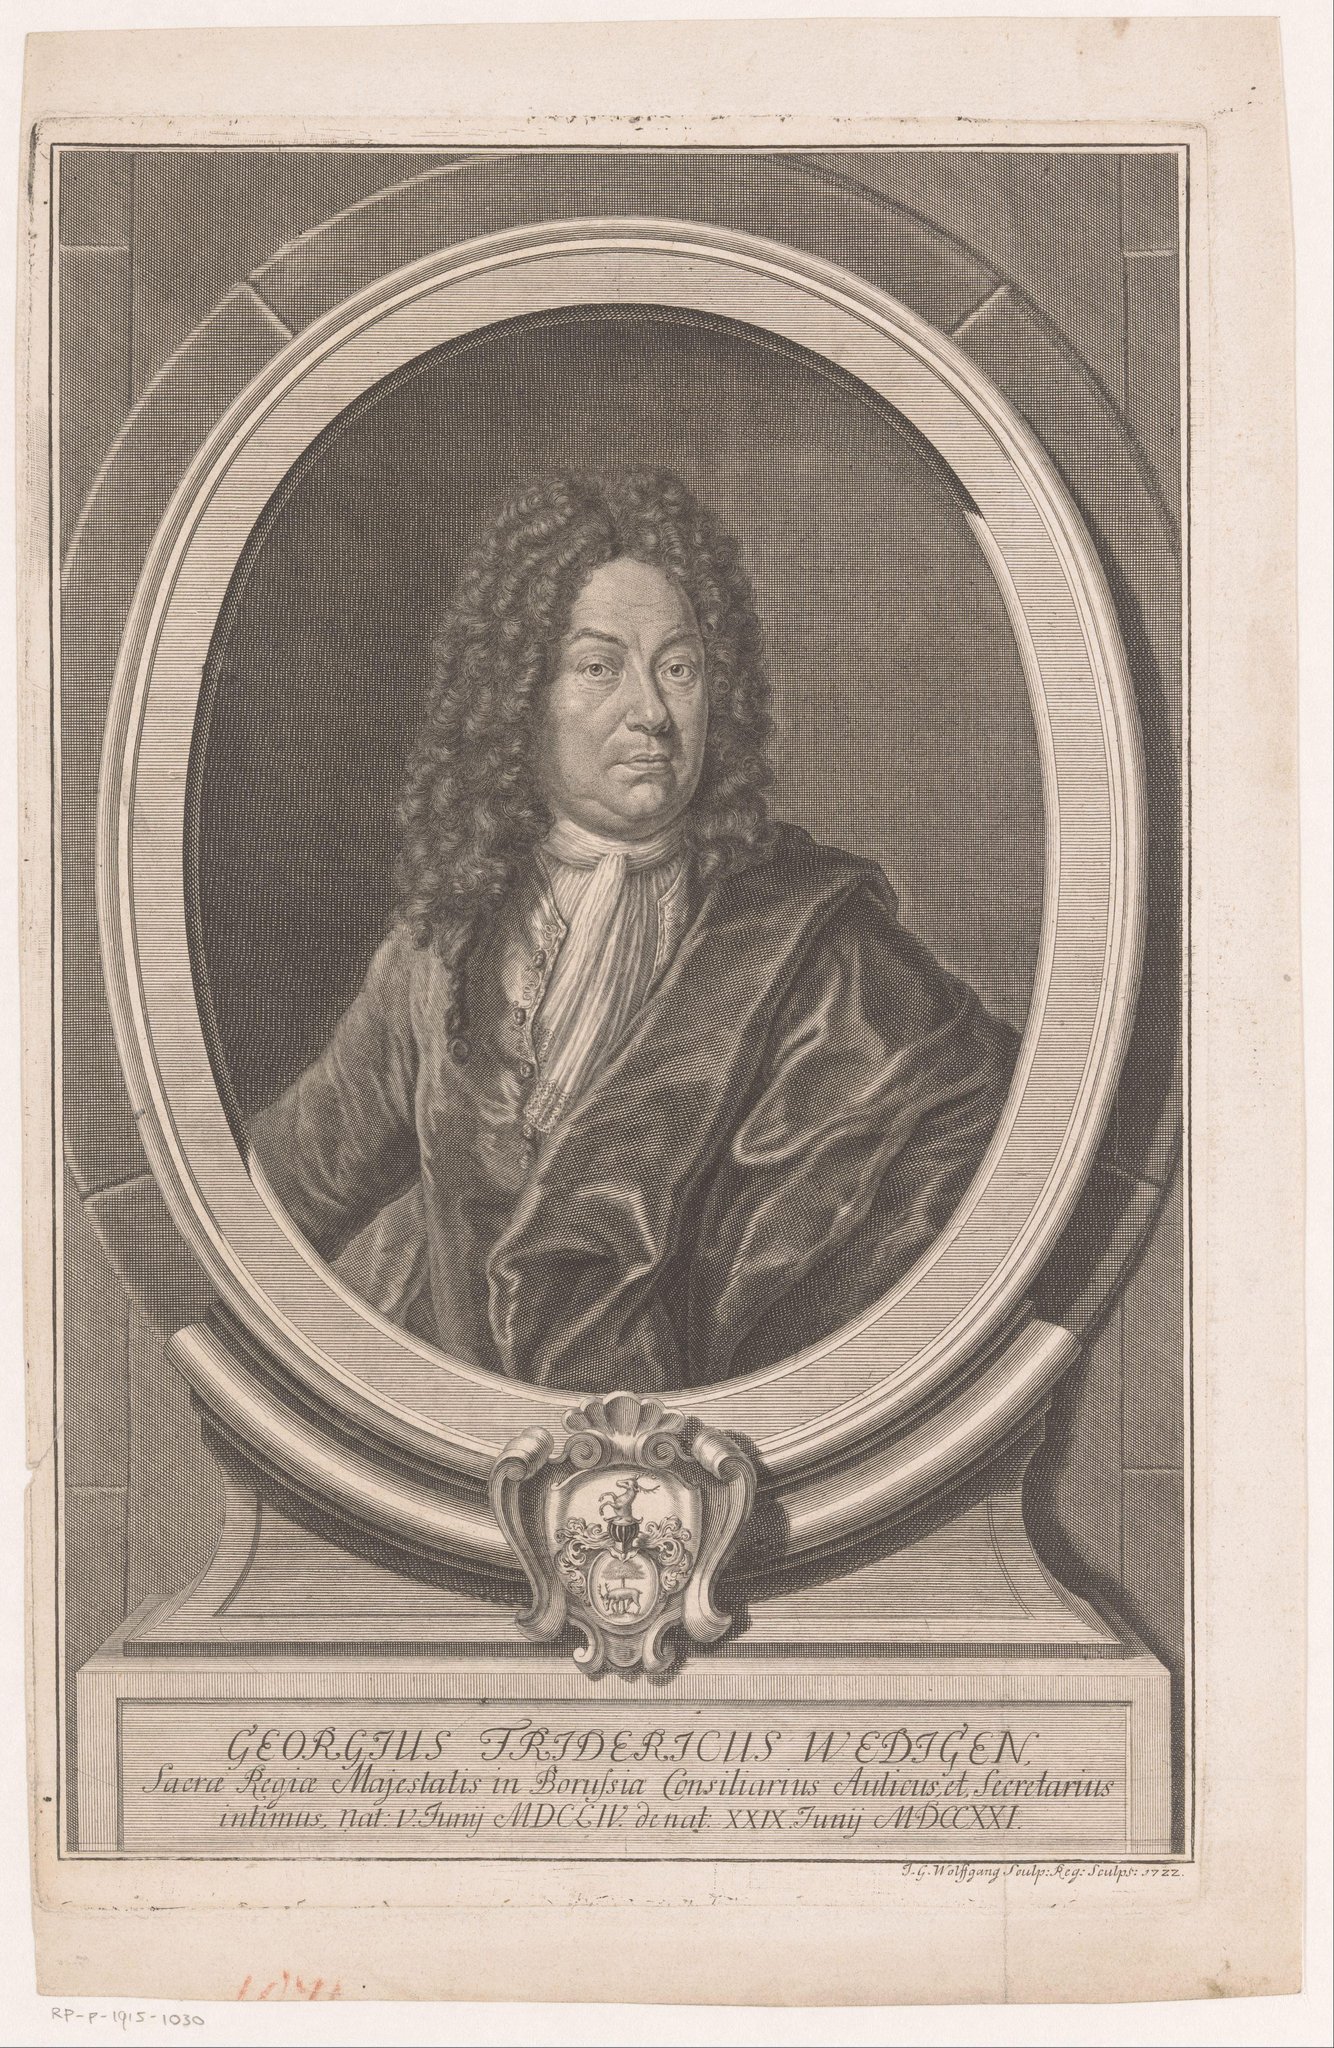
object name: print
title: Portret van Georg Friedrich von Wedigen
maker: johann georg wolfgang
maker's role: graveur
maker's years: 1662-1744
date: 1722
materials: paper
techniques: engraving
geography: germany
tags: historical persons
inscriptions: collector's mark: Lugt 2228